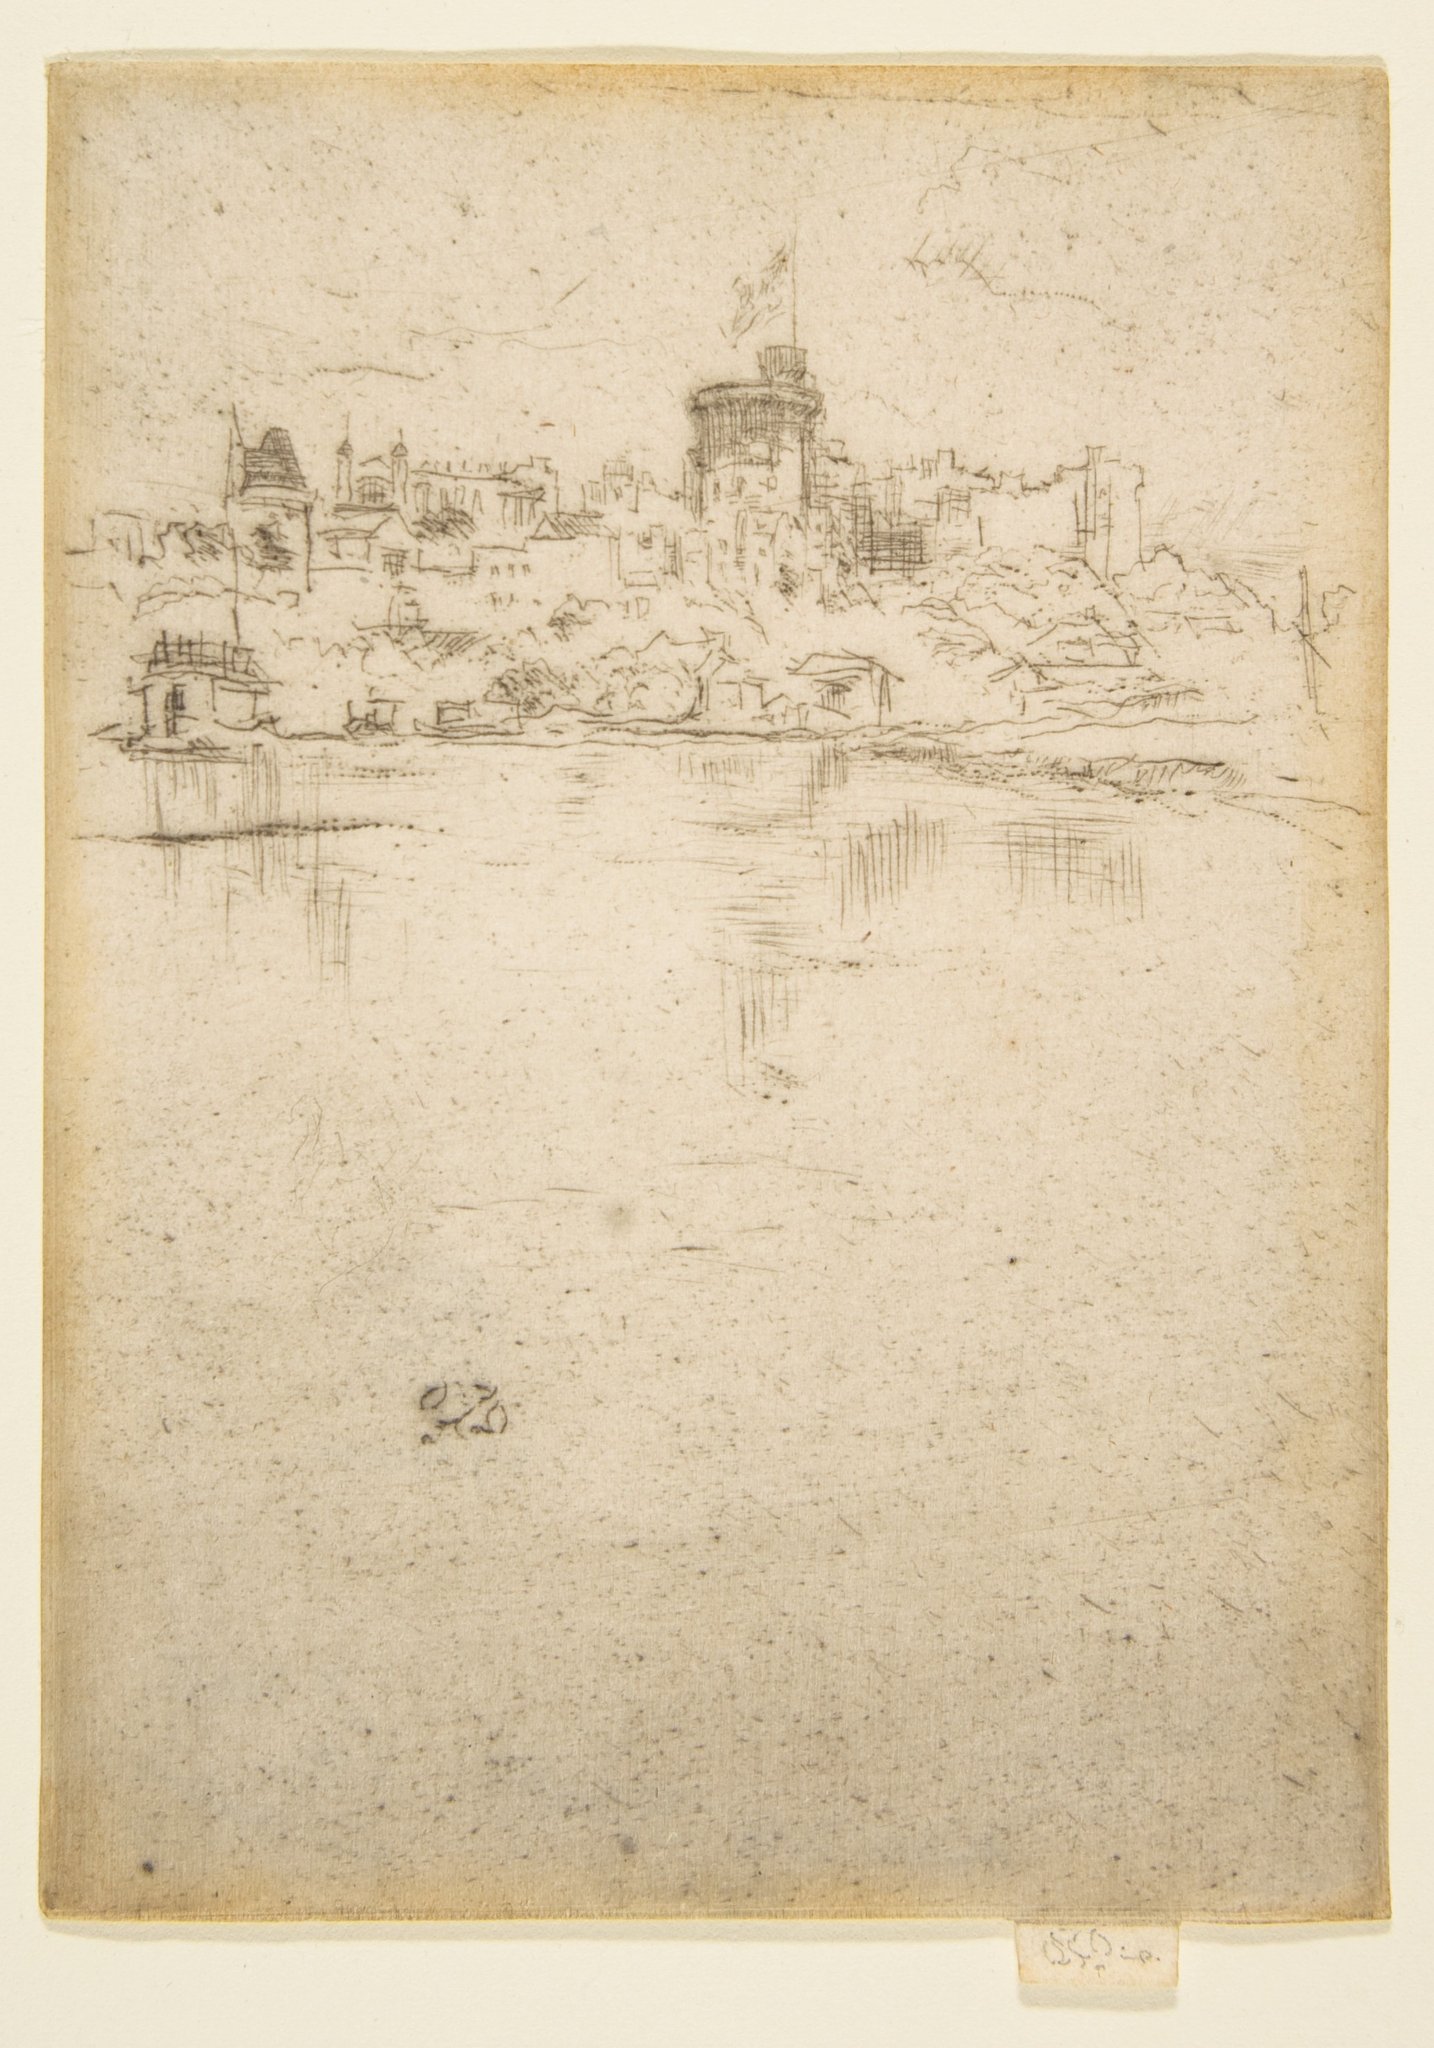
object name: print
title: Windsor (Memorial)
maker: james mcneill whistler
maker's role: artist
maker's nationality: american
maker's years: 1834-1903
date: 1887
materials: ink, paper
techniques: drypoint, printing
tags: houses,rivers